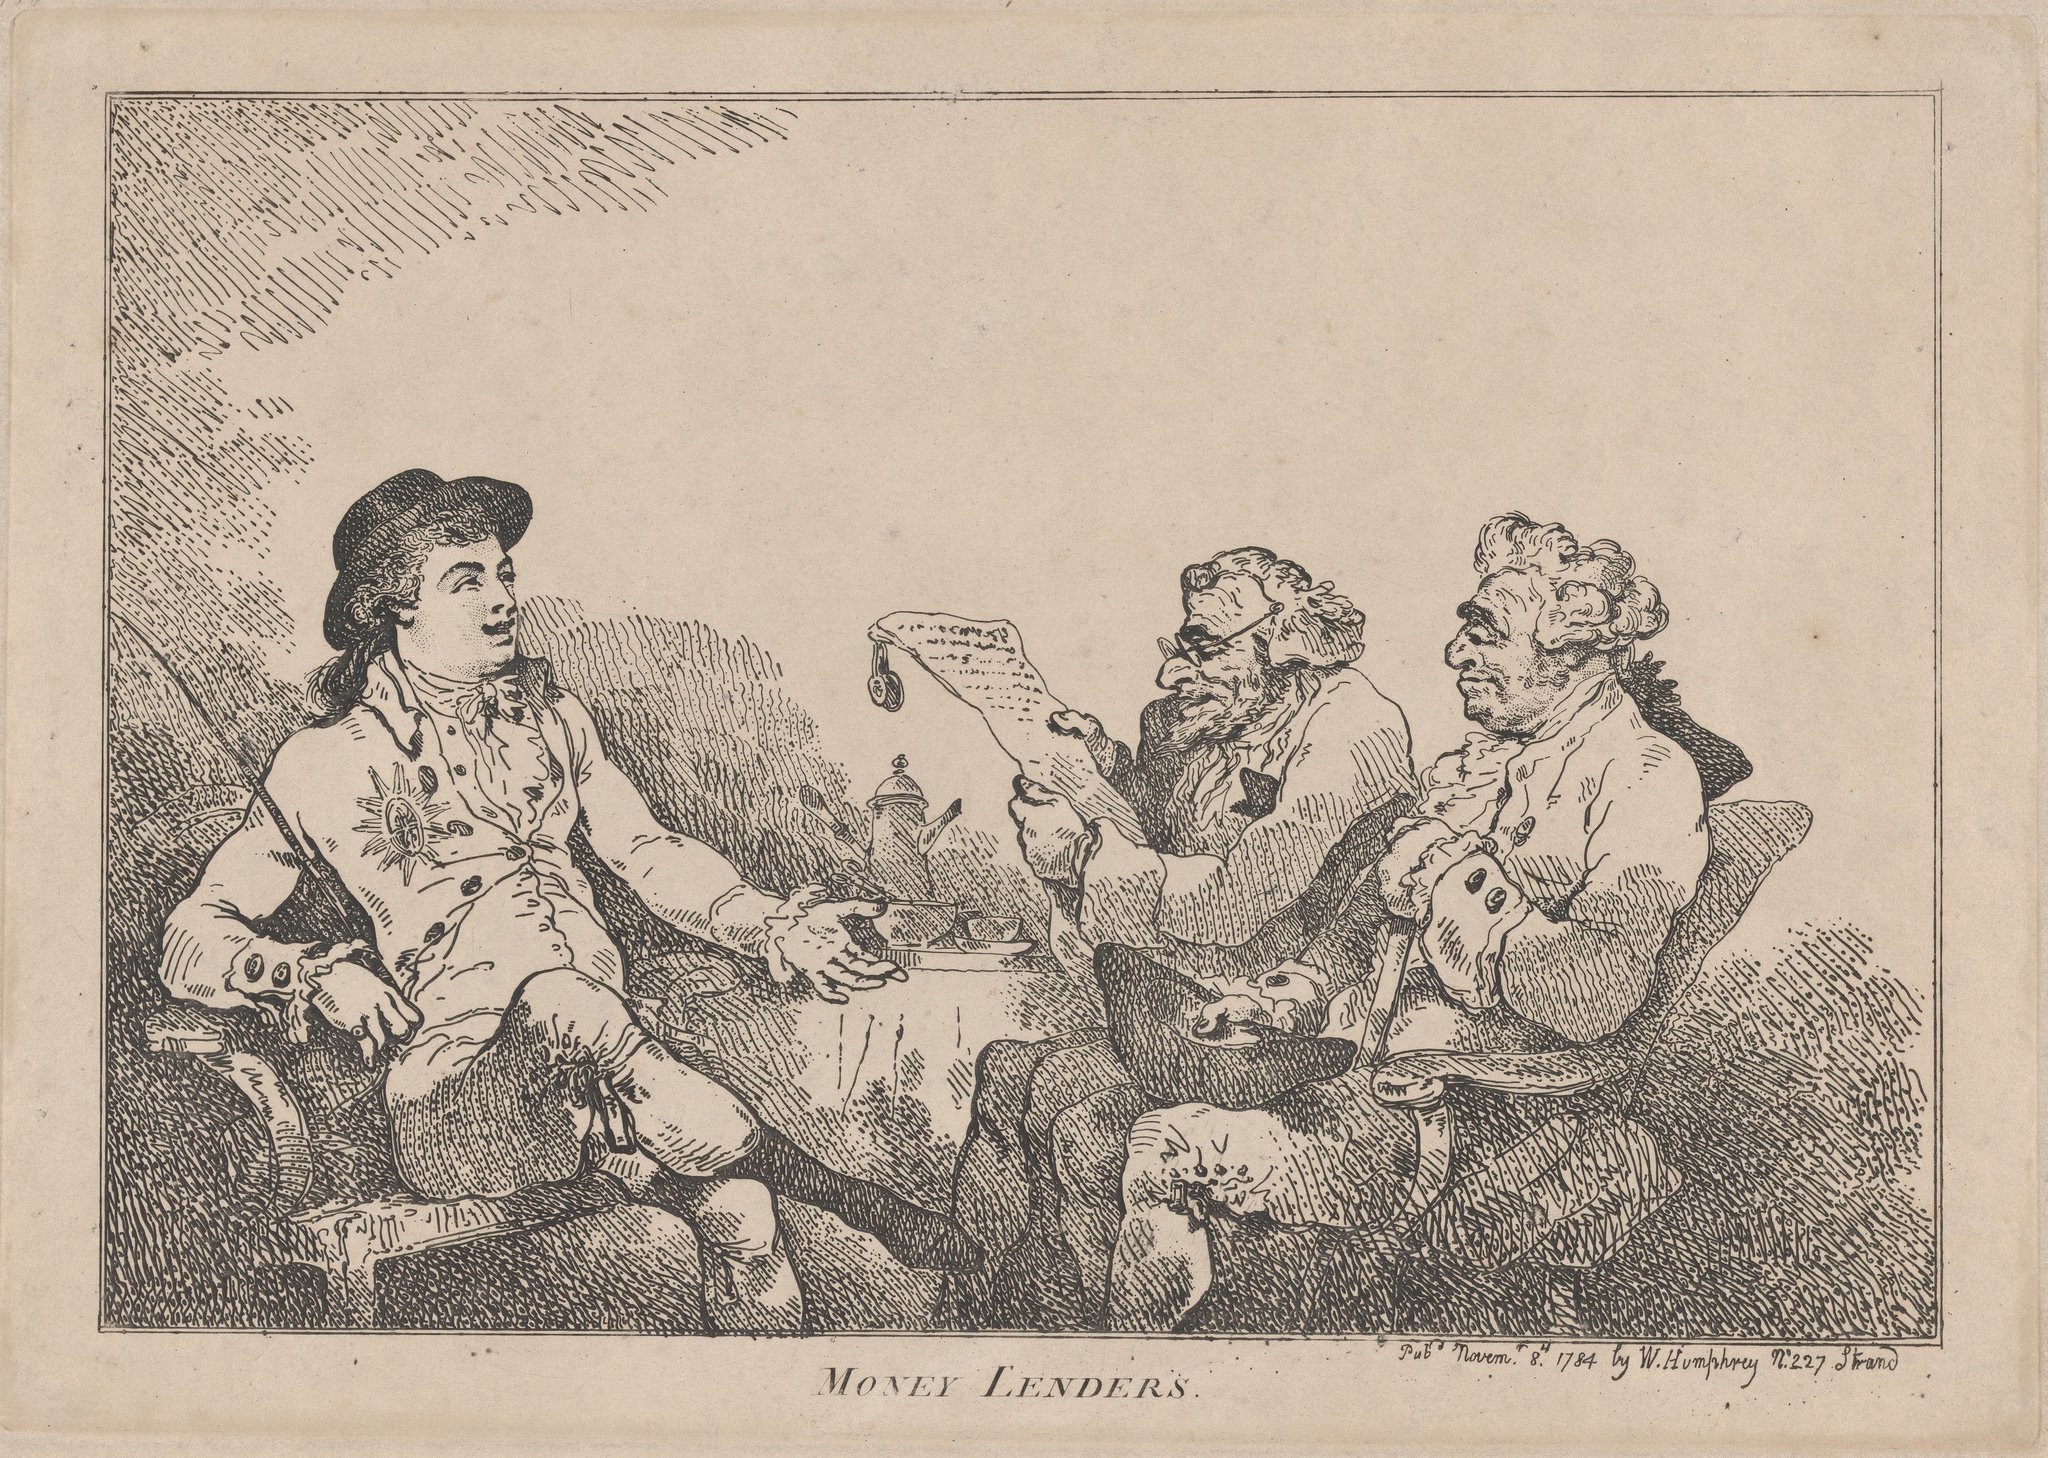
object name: print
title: Money Lenders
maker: thomas rowlandson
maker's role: artist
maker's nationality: british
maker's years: 1757-1827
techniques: etching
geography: london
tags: satire,men